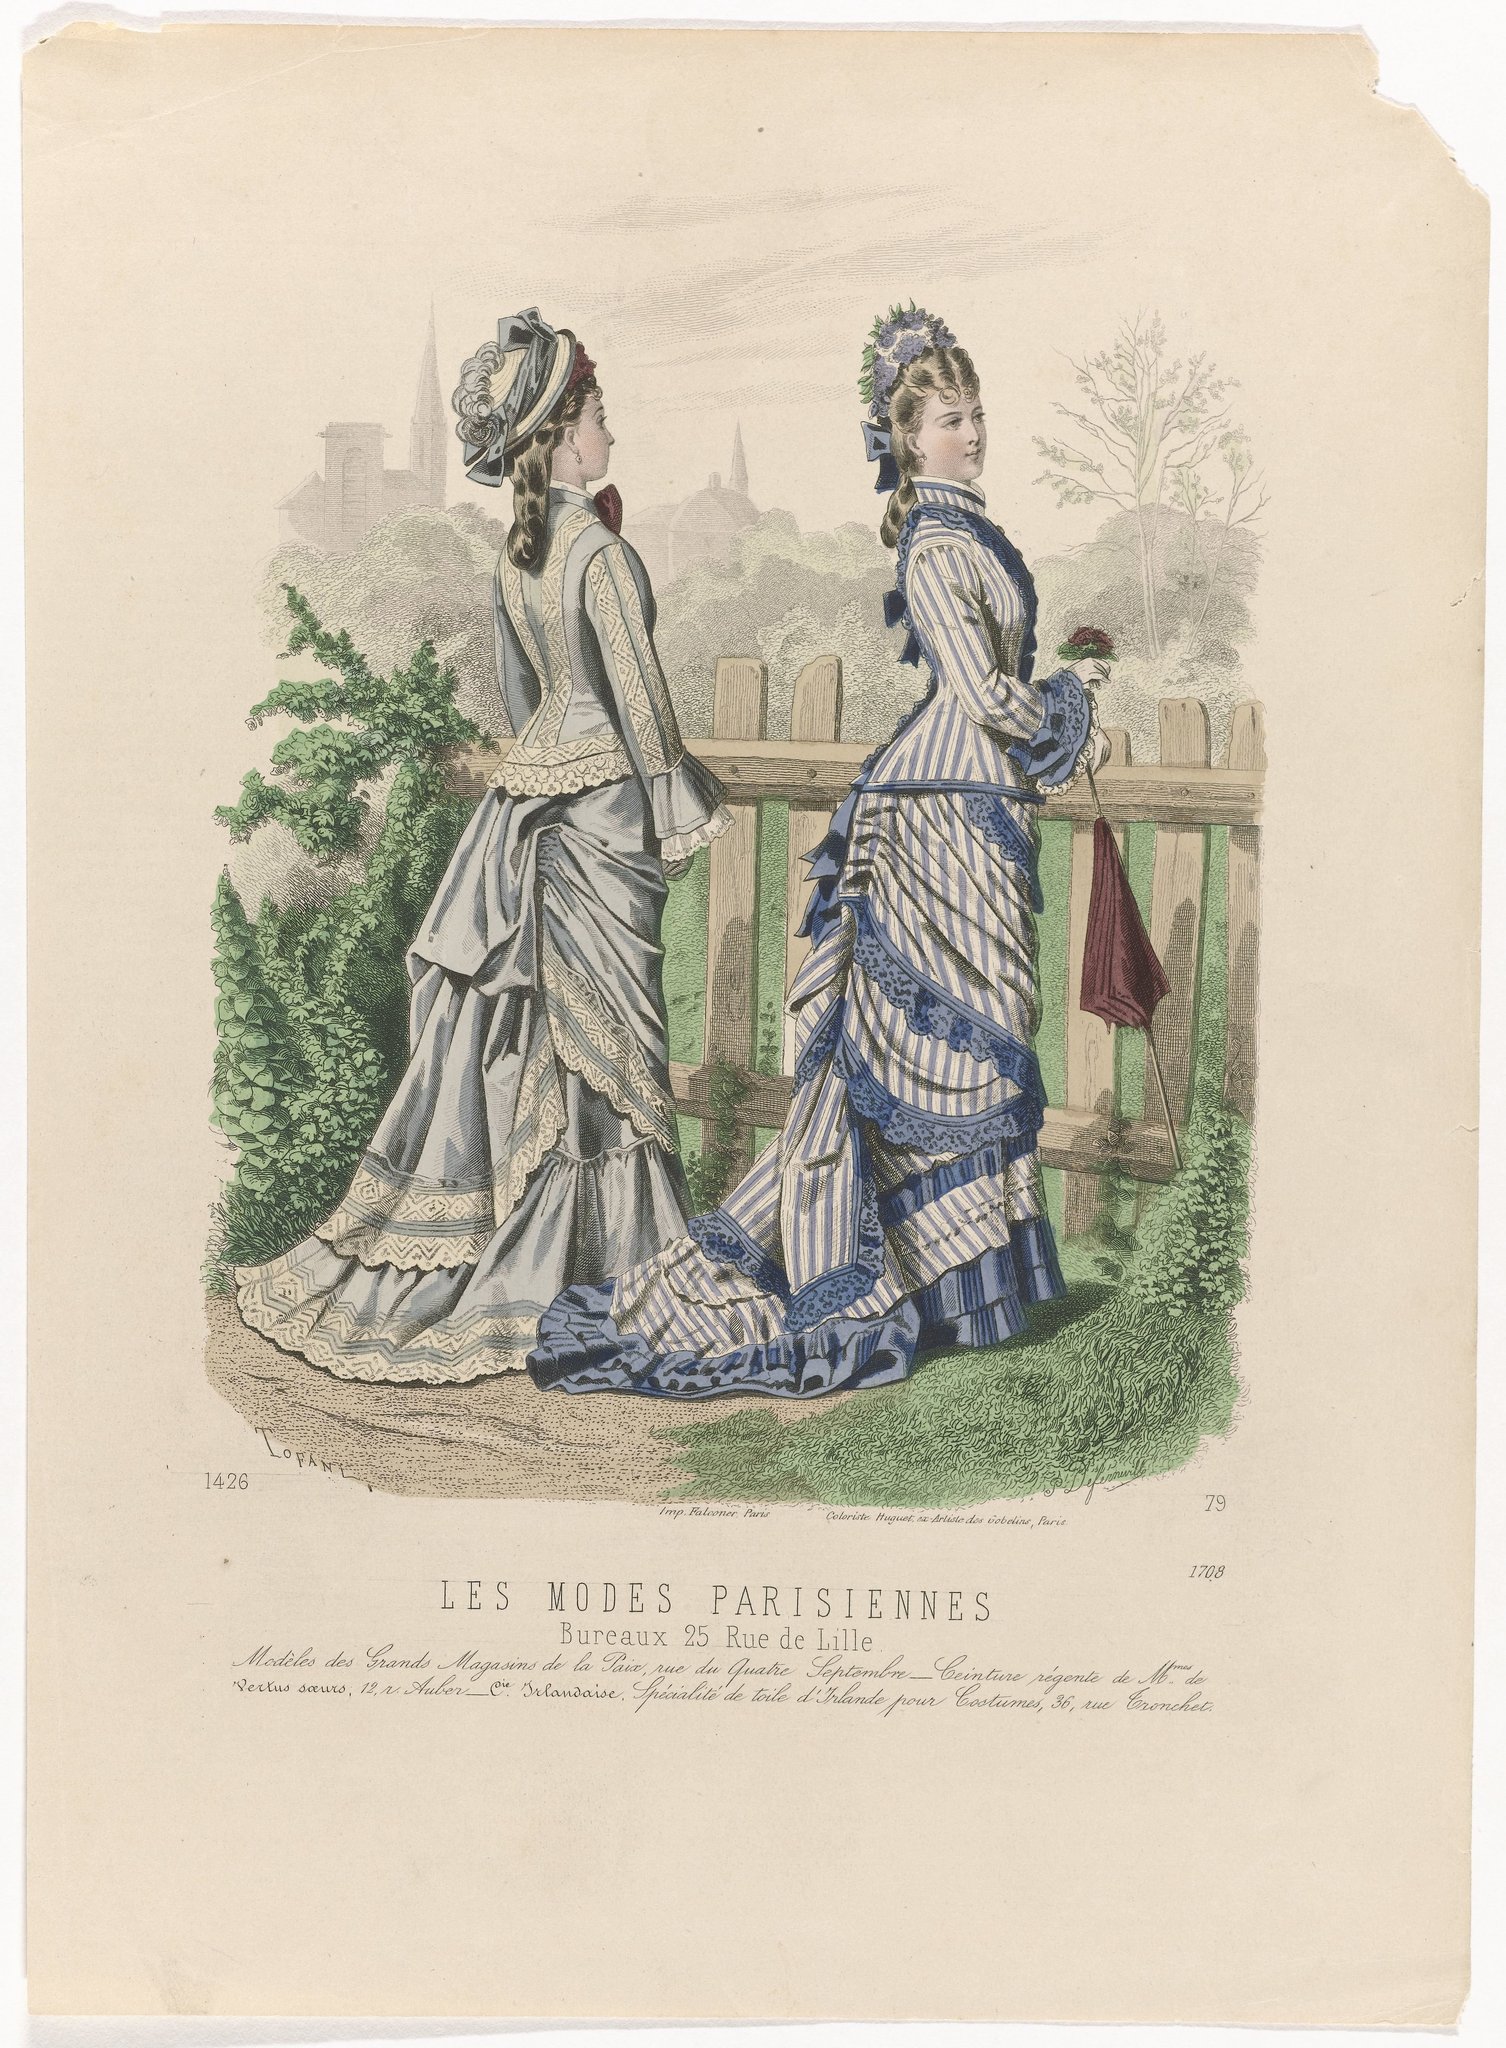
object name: fashion print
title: Les Modes Parisiennes, ca. 1876, No. 1708, No.1426 : Modèles des Grands Magasins (...)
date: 1876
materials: paper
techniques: engraving, hand coloring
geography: paris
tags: cut flowers; nosegay, bunch of flowers, fence, wall, paling, fashion plates, head-gear: hat (+ women's clothes), skirt (+ women's clothes), gloves, mittens, etc. (+ women's clothes), dress, gown (+ women's clothes), parasol, sunshade (+ women's clothes)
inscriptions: address: ‘Bureau 25 Rue de Lille’, title: ‘Les Modes Parisiennes’, caption: ‘Modèles des Grands Magasins de la Paix, rue du Quatre Septembre _ Ceinture régente de Mmes de Vertus Soeurs,12, r. Auber _ Cie Irlandaise. Spécialité de toile d'Irlande pour Costumes,36,rue Tronchet.’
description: Twee vrouwen, van wie één op de rug gezien, bij een hek. Volgens het onderschrift zijn de japonnen van het warenhuis Grands Magasins de la Paix. Hieronder enkele regels reclametekst voor verschillende producten. Prent uit het modetijdschrift Les Modes Parisiennes (1843-1885).